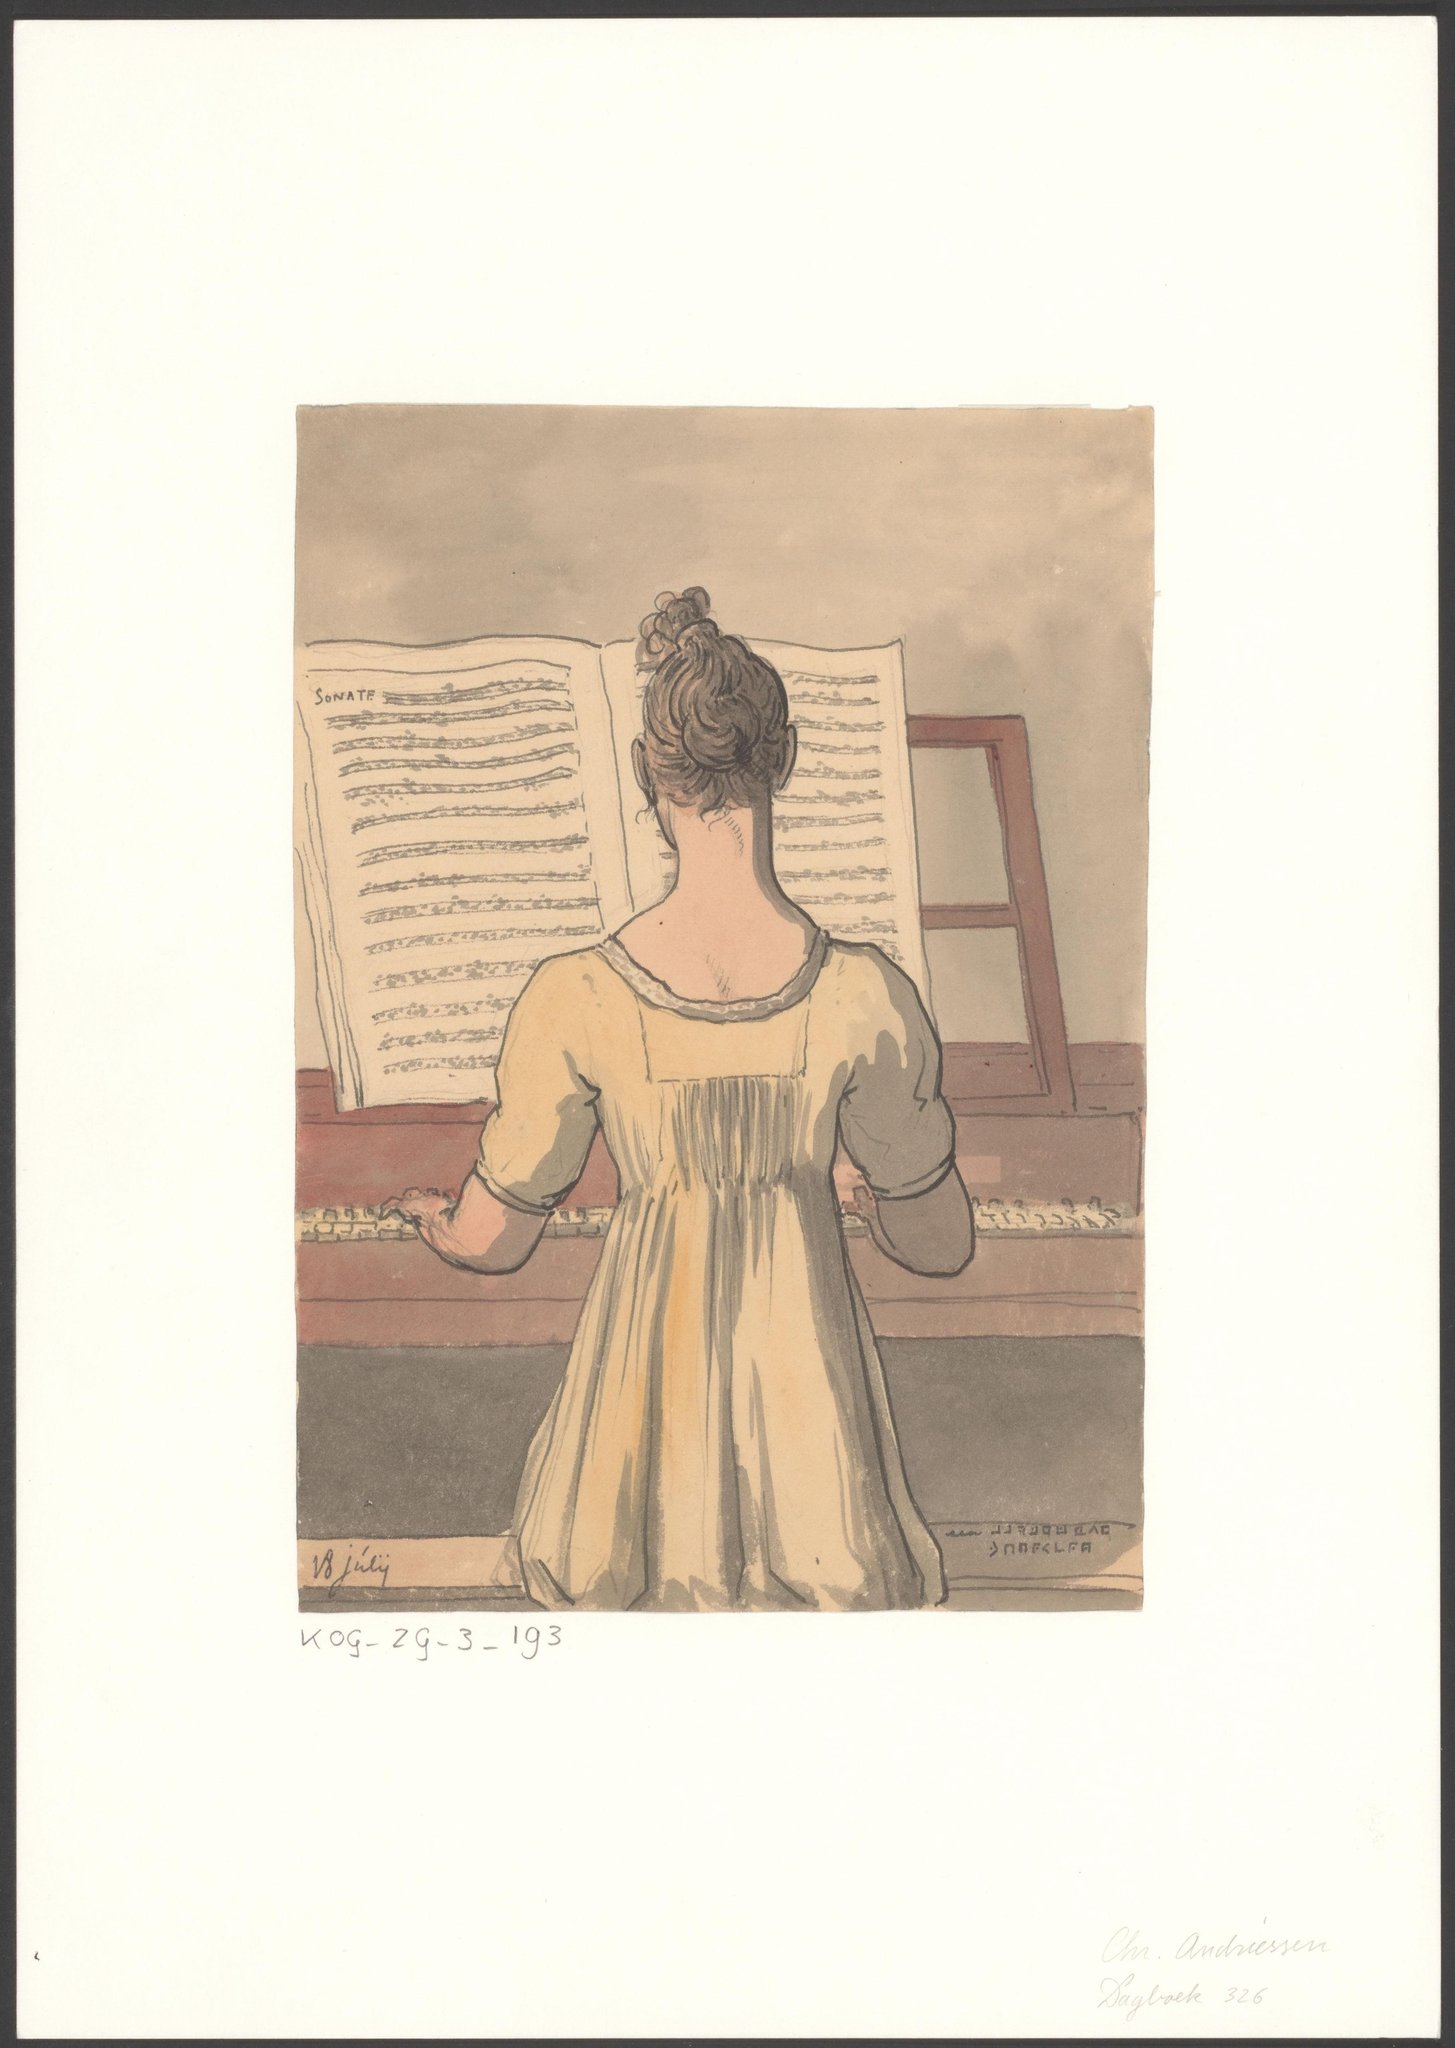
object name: drawing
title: Jongedame op de rug gezien terwijl zij de fortepiano speelt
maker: christiaan andriessen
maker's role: draughtsman, print maker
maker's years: 1775-1846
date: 1805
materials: ink, paper, pencil, watercolor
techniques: brush, pen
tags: one person playing an instrument, pianoforte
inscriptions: signature: ‘J Andriessen’, inscription: ‘18 junij een aanbidlijk voorwerp’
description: Dagboekblad uit het getekende dagboek dat Christiaan Andriessen bijhield van 1805 tot en met 1808.